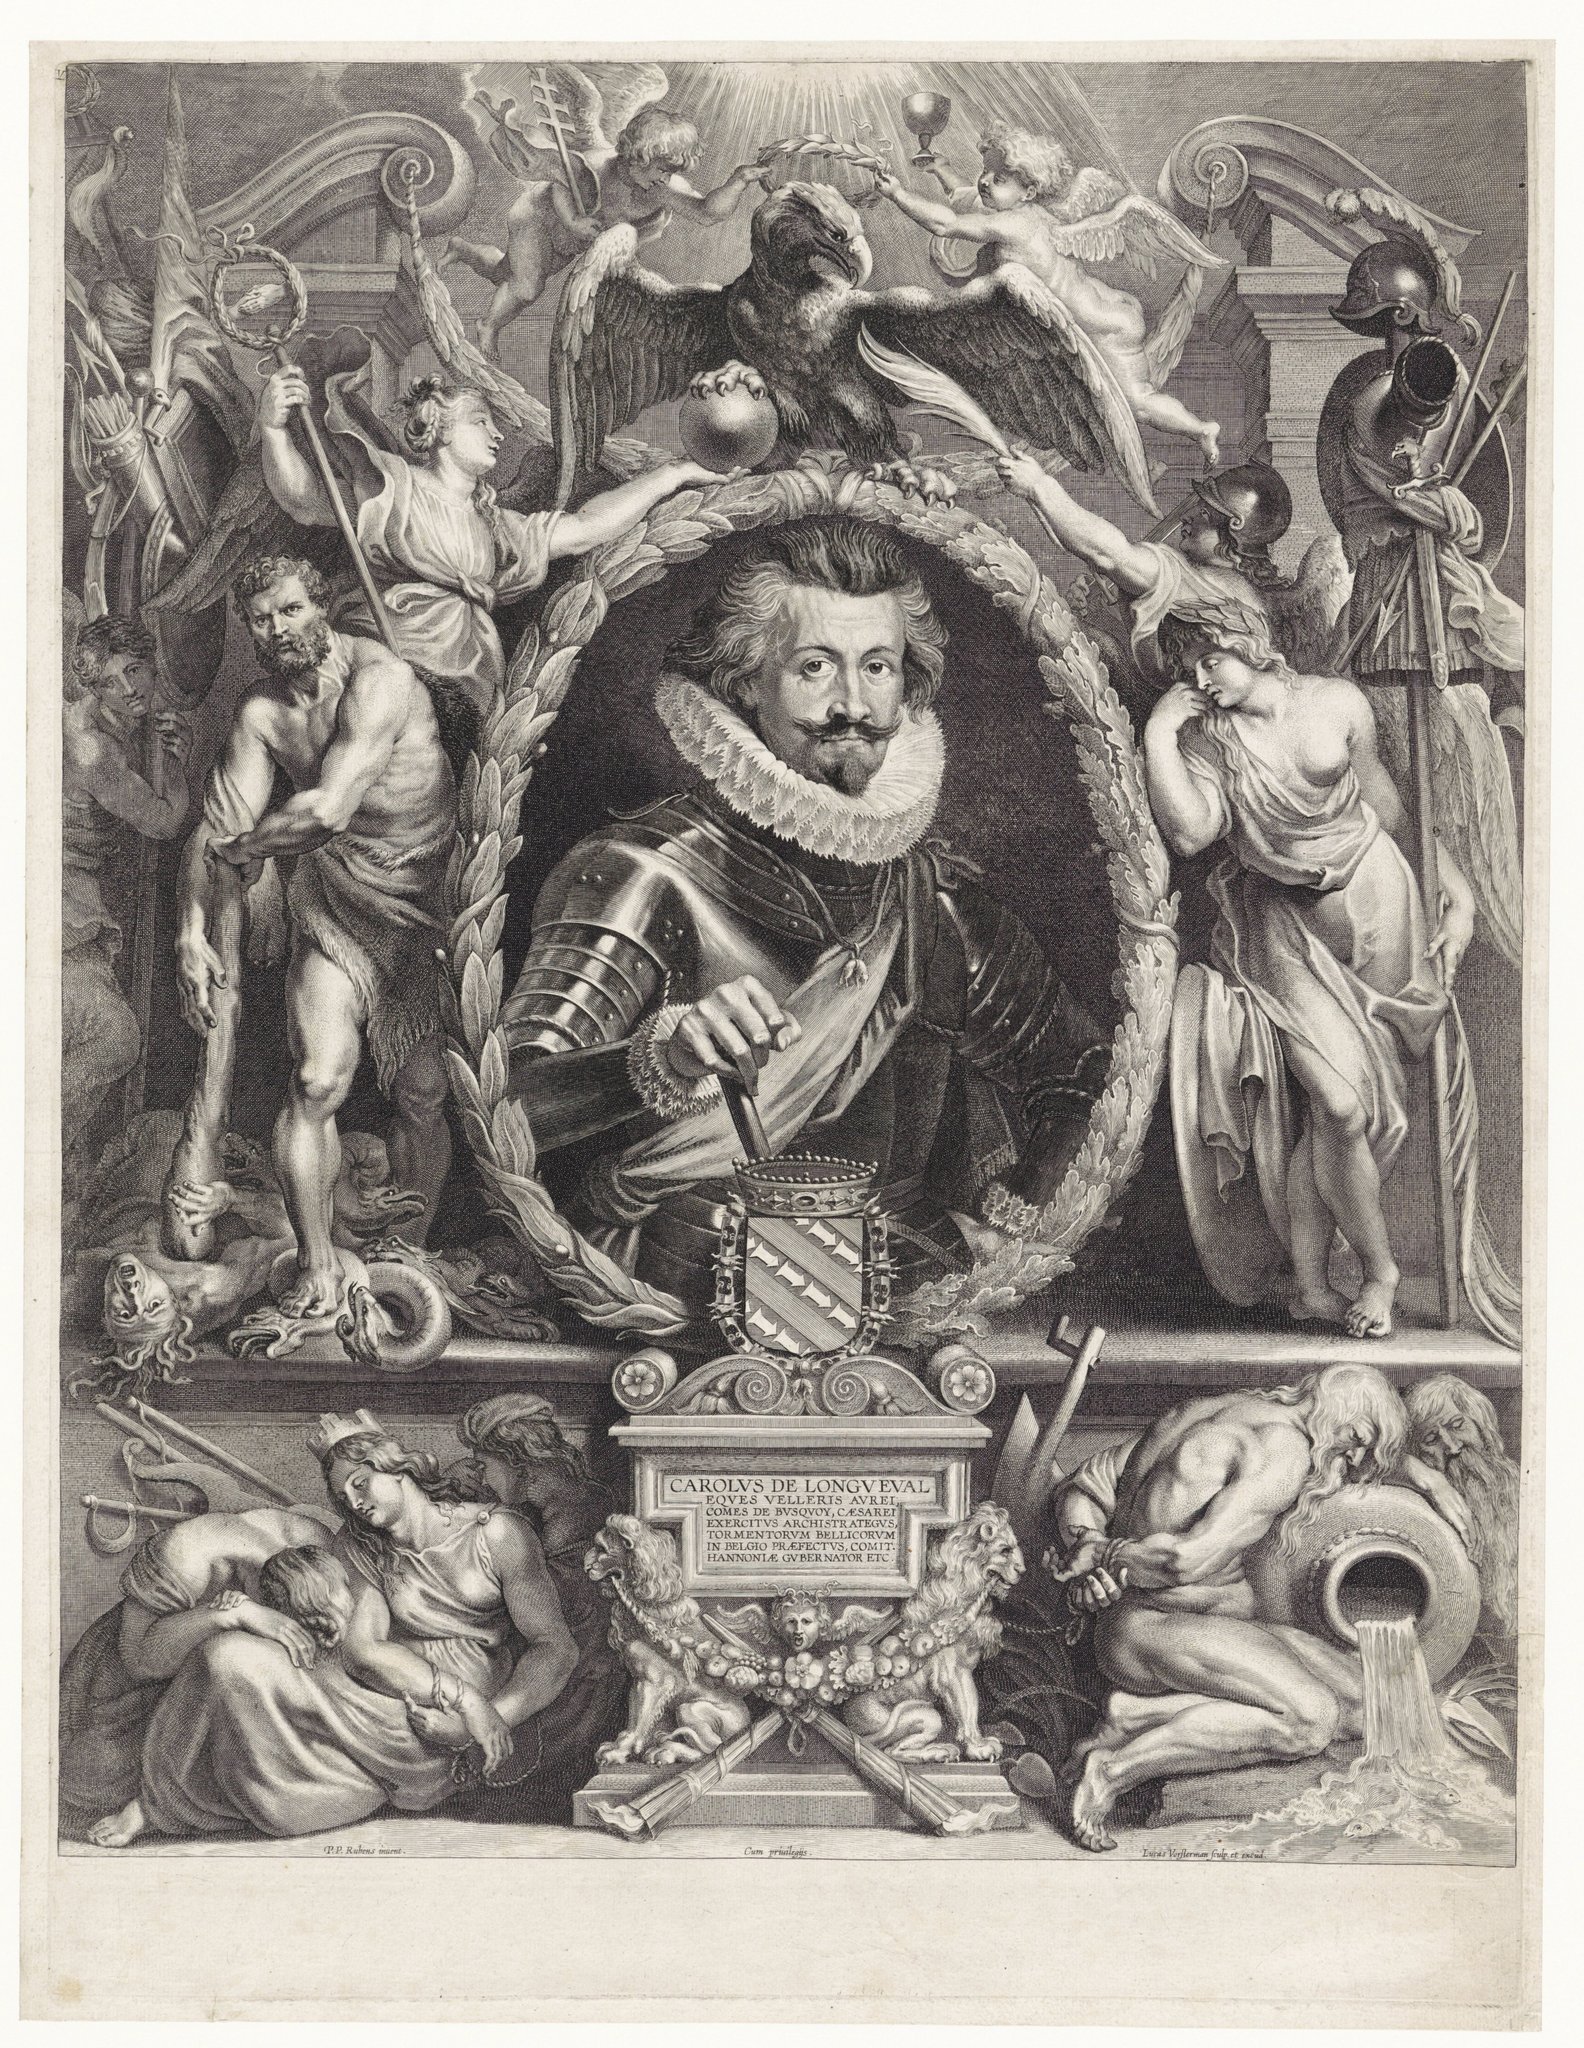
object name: print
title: Portret van Charles-Bonaventure de Longueval, graaf van Bucquoy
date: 1621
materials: paper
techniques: engraving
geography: antwerp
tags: (story of) hercules (heracles)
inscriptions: collector's mark: Lugt 240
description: Allegorisch portret op het overlijden van Charles-Bonaventure de Longueval, graaf van Bucquoye. De krijgsman wordt in de ornamentale omlijsting door Hercules en allegorische figuren omringd.